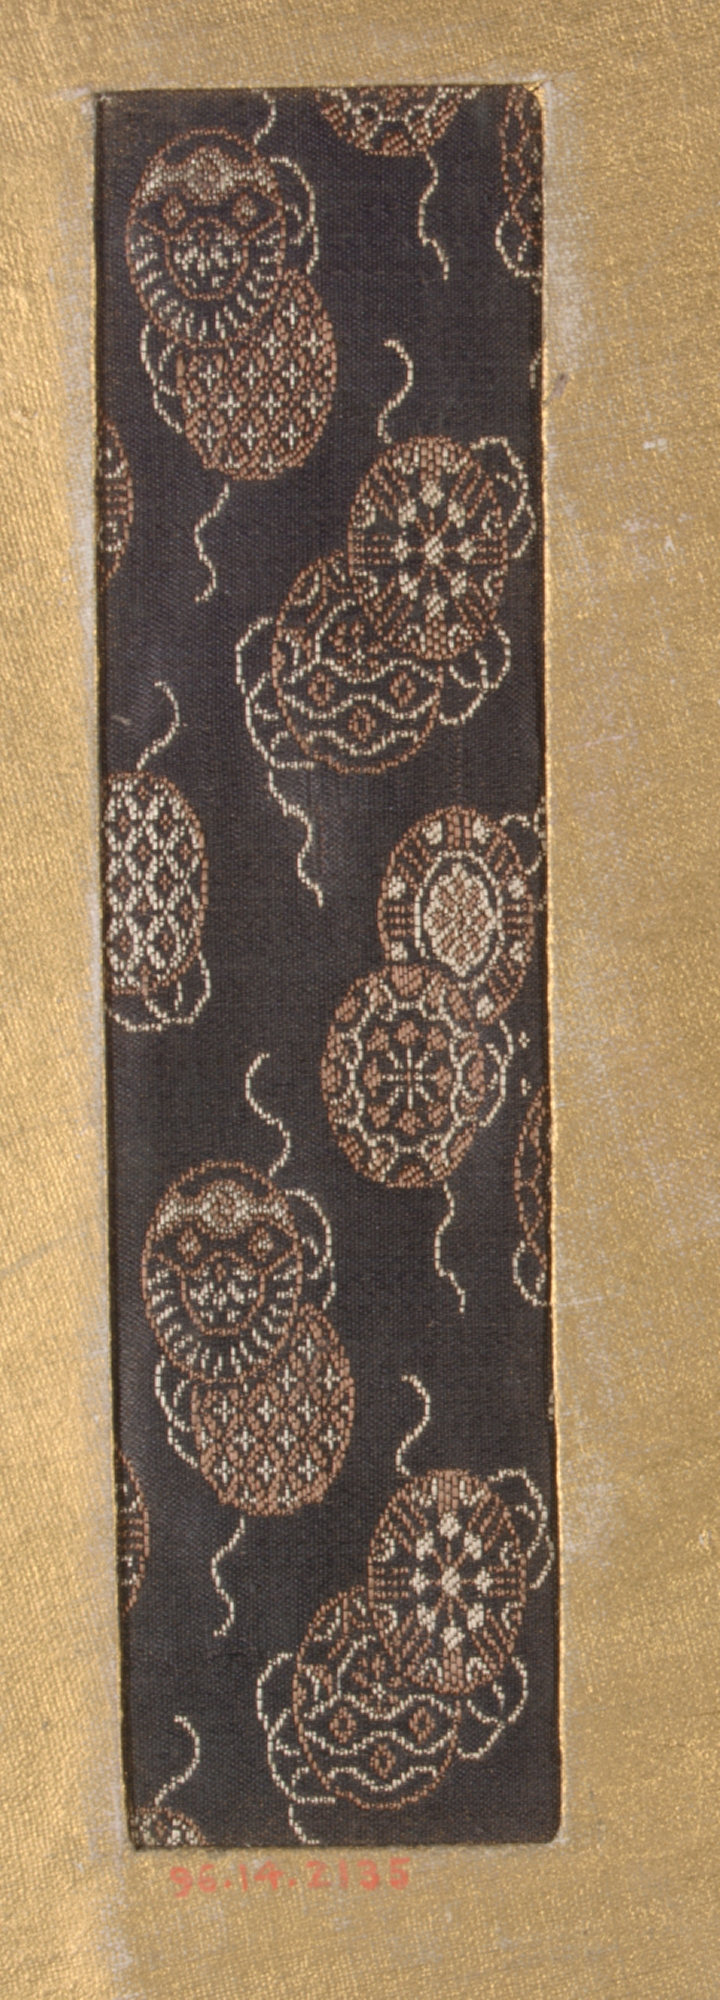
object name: piece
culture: japanese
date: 1701-1900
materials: silk